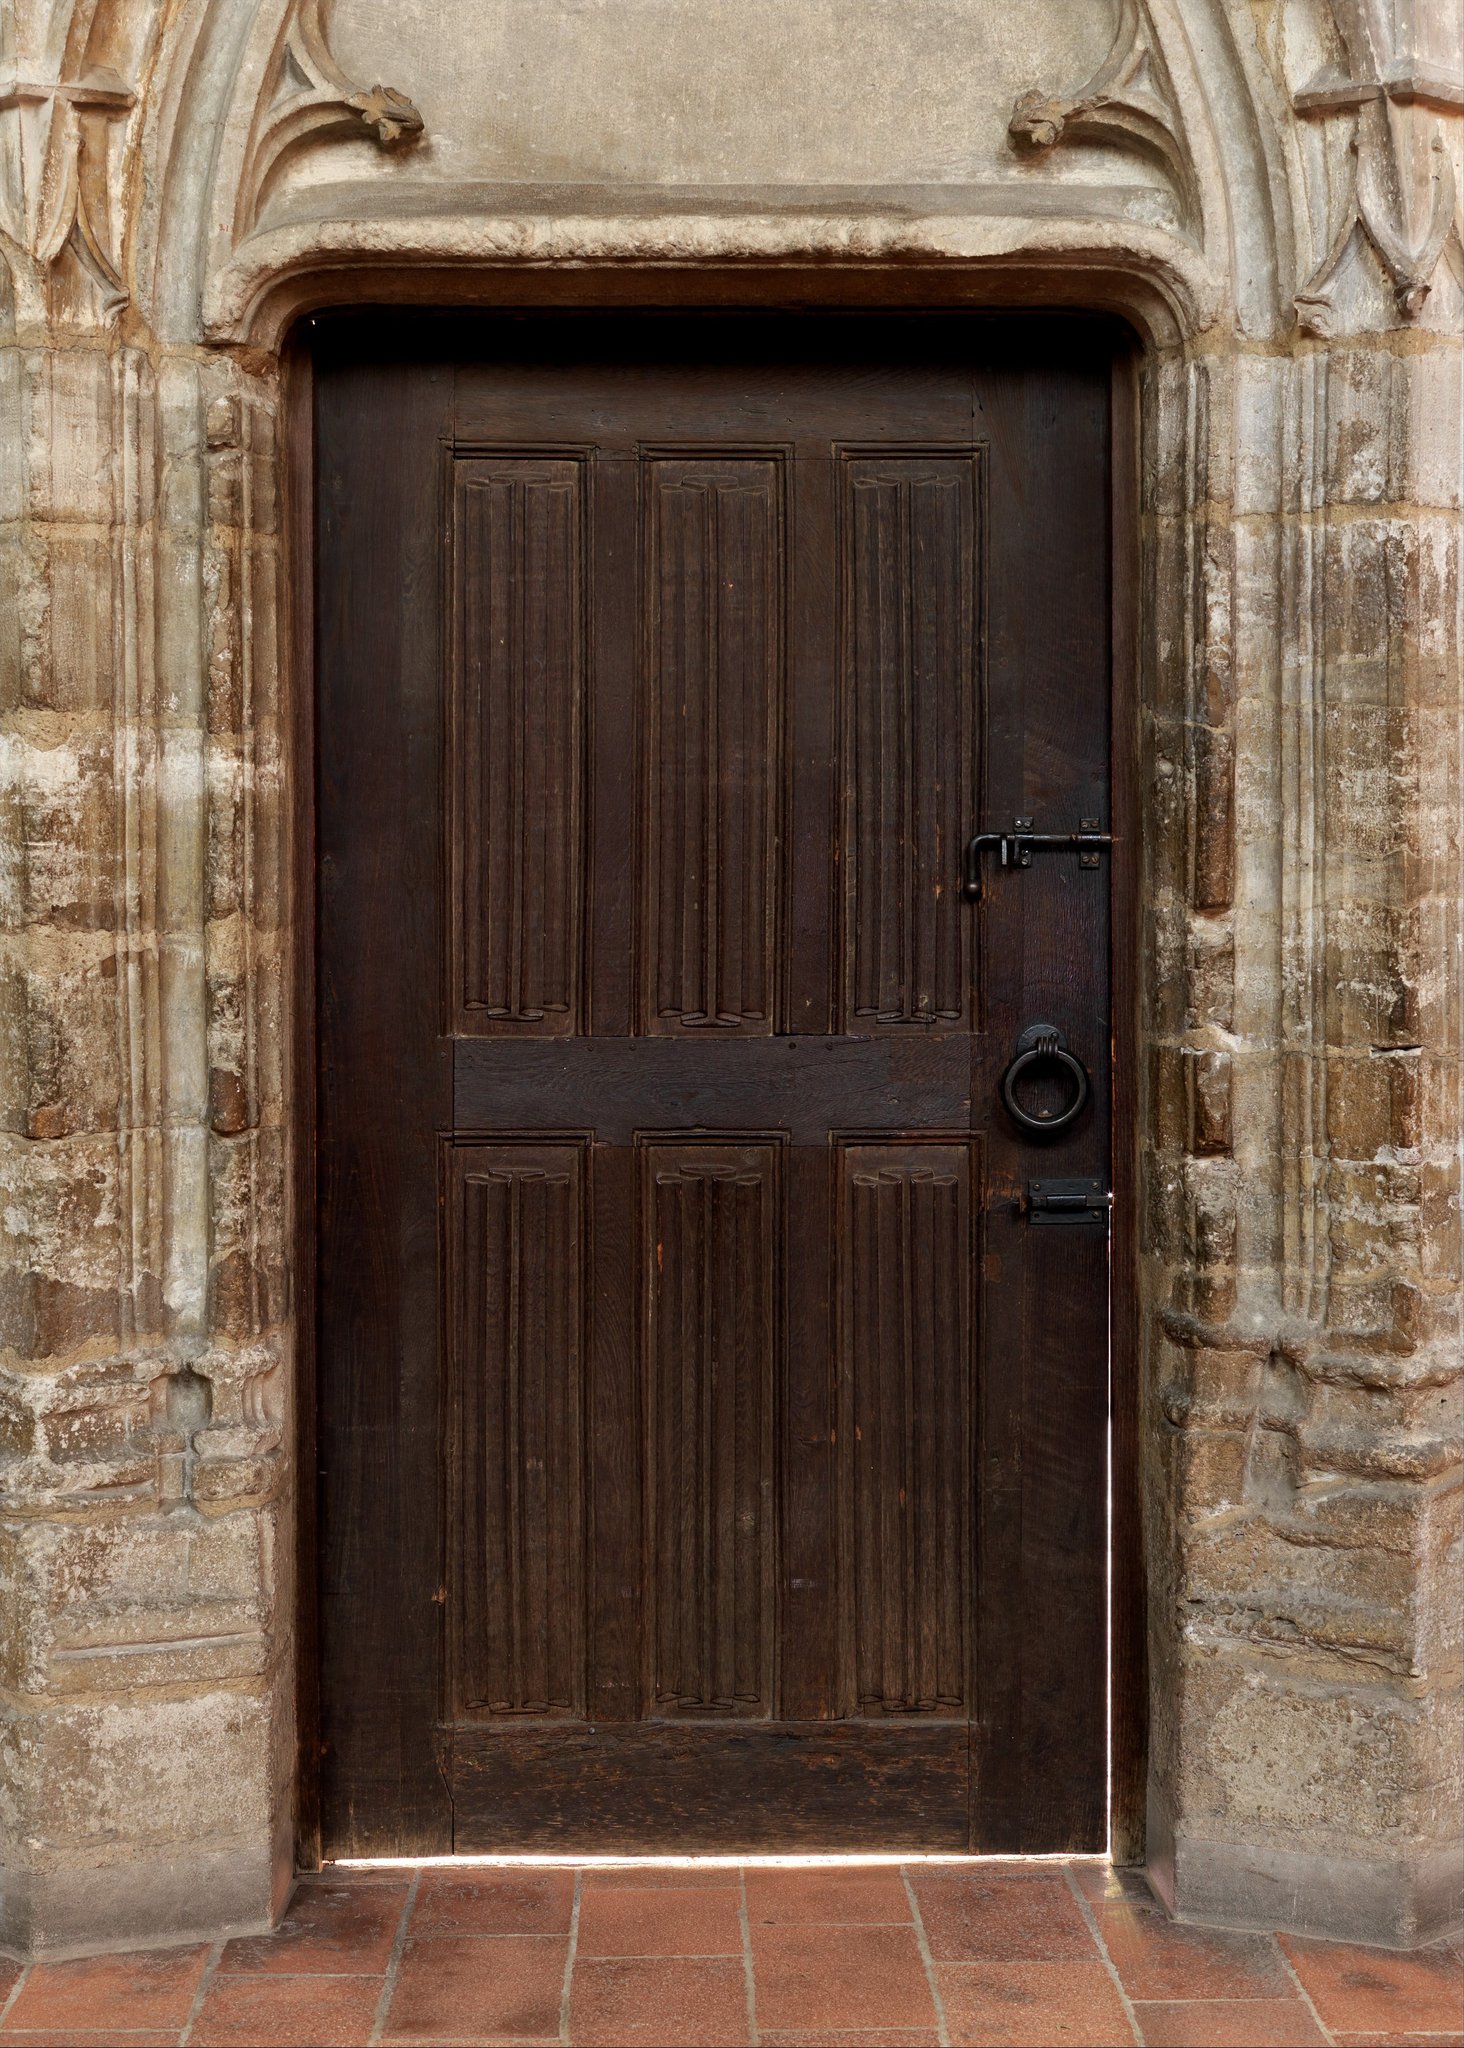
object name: door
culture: french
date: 1401-1500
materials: wood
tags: doors